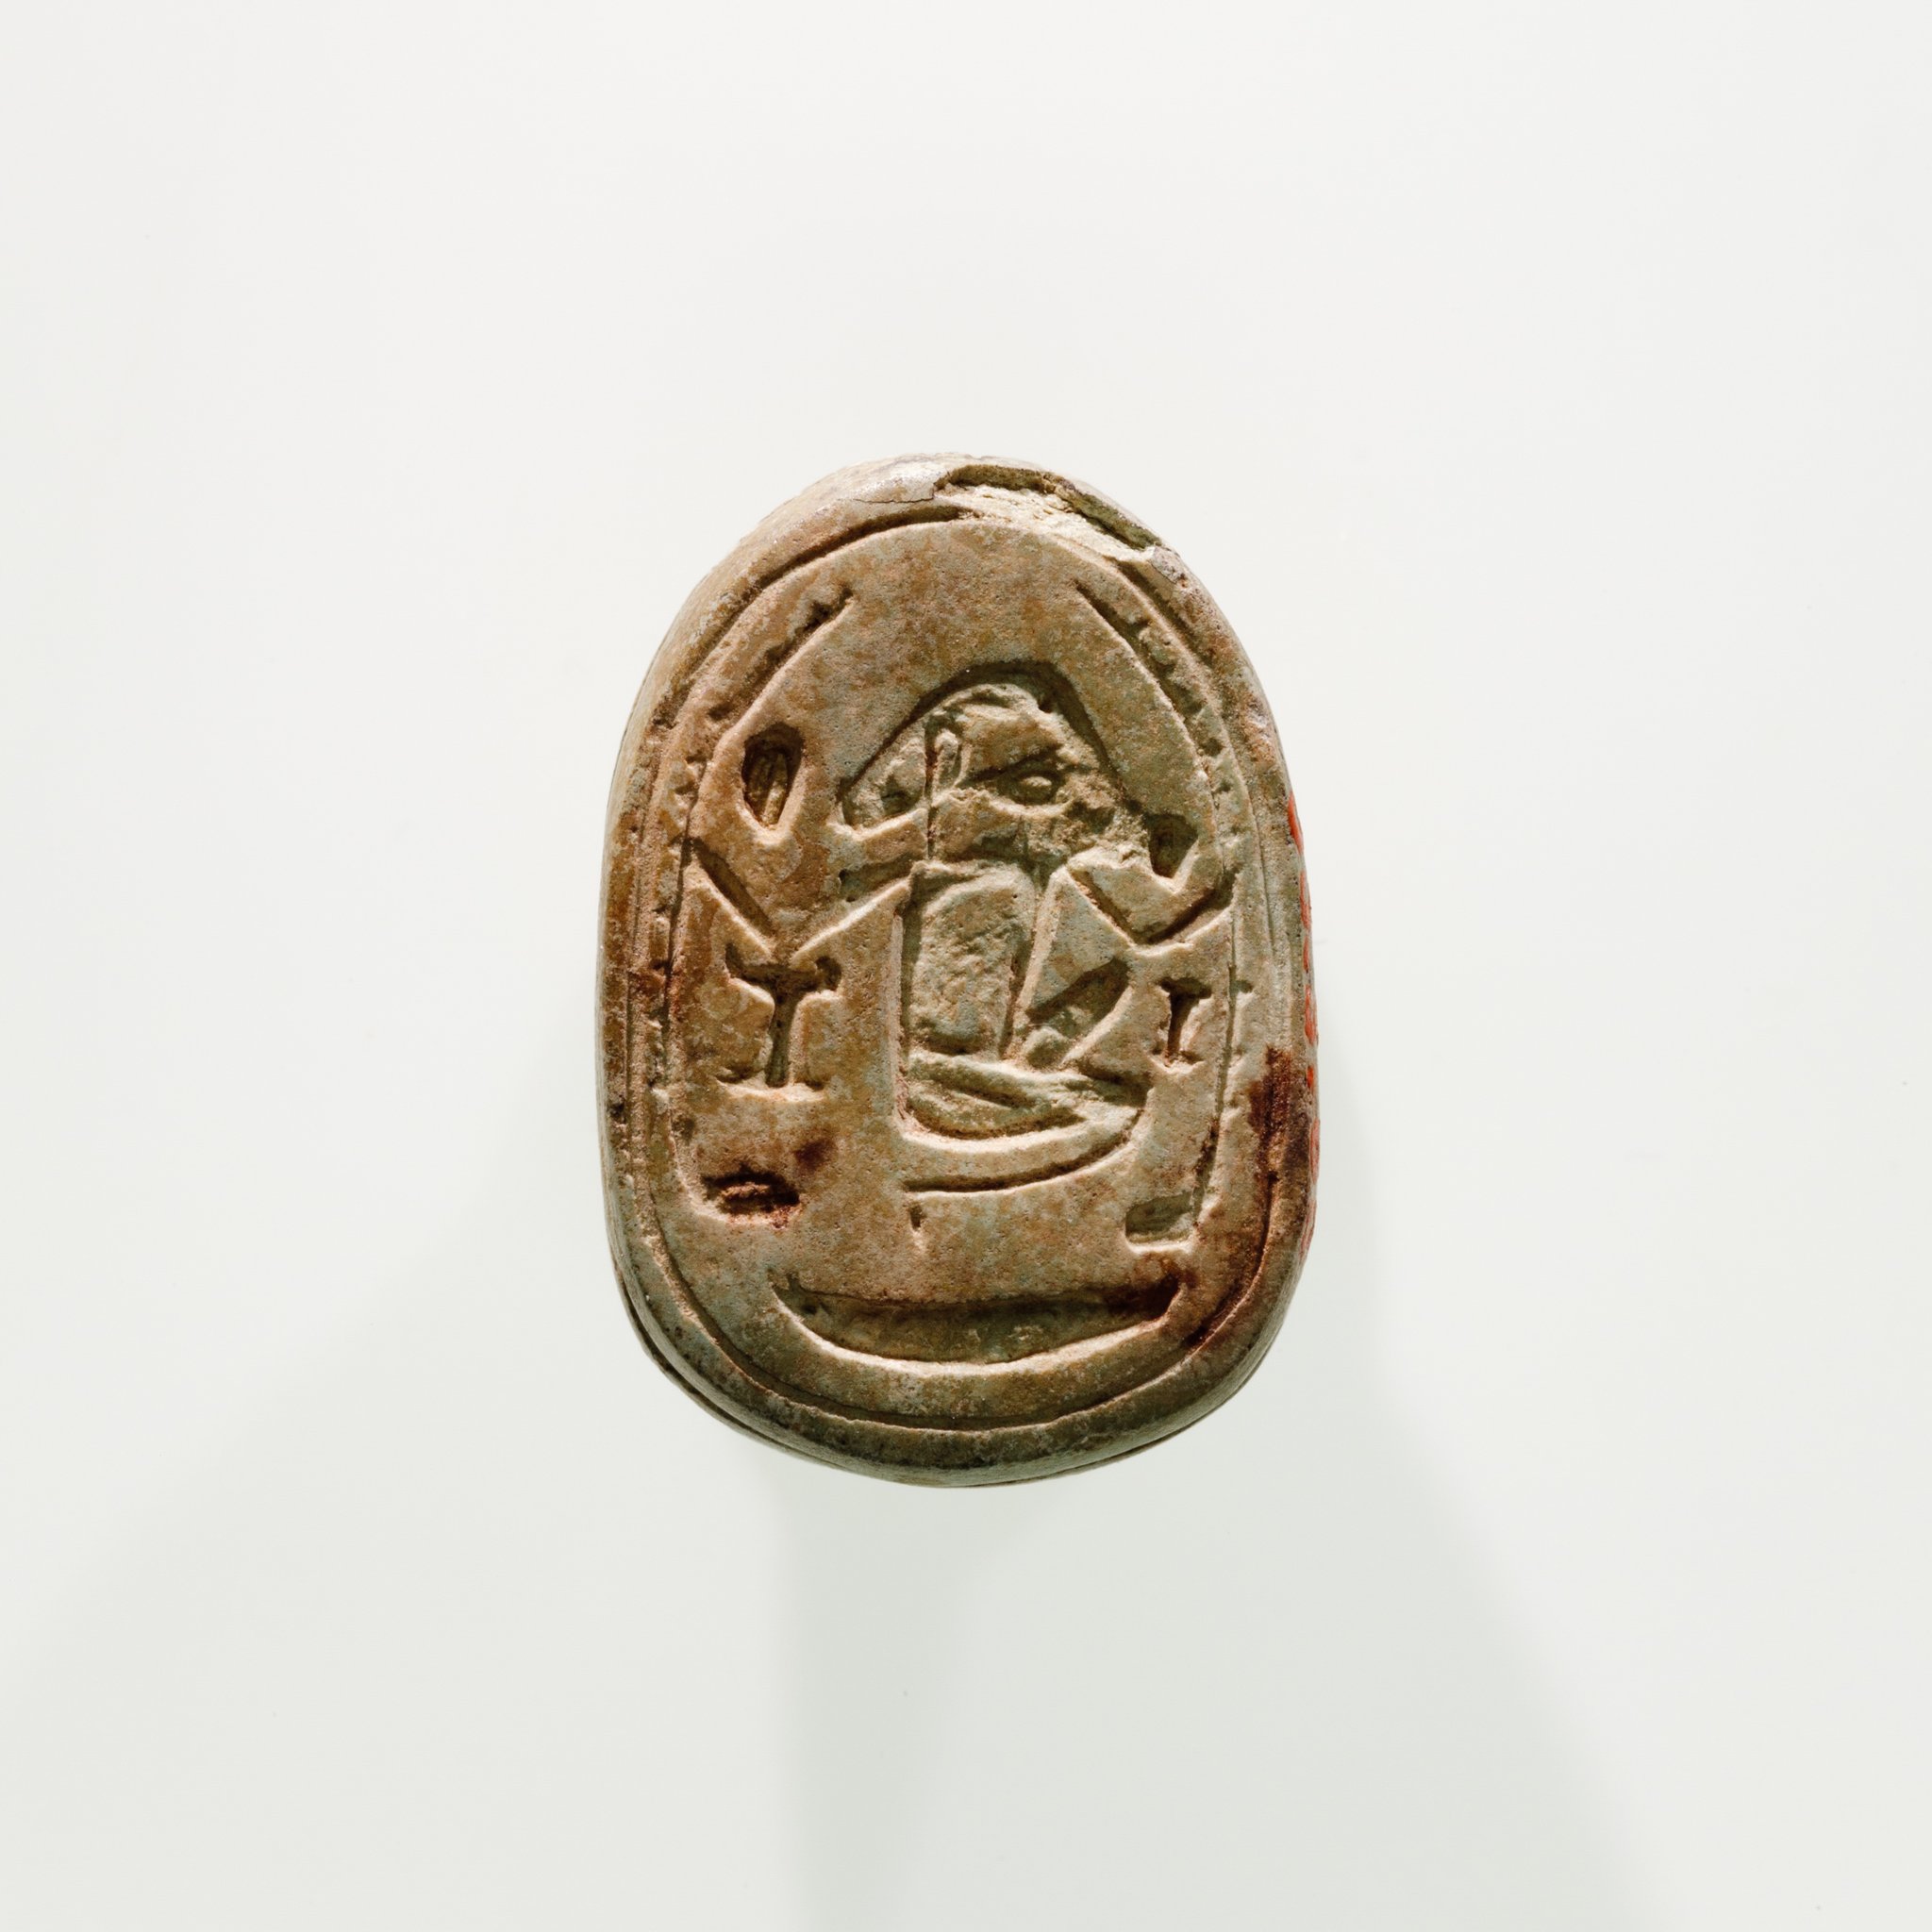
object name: scarab, million of year, rennefer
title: Scarab from Rennefer's Burial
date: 1504-1447 BCE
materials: faience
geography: egypt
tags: scarabs